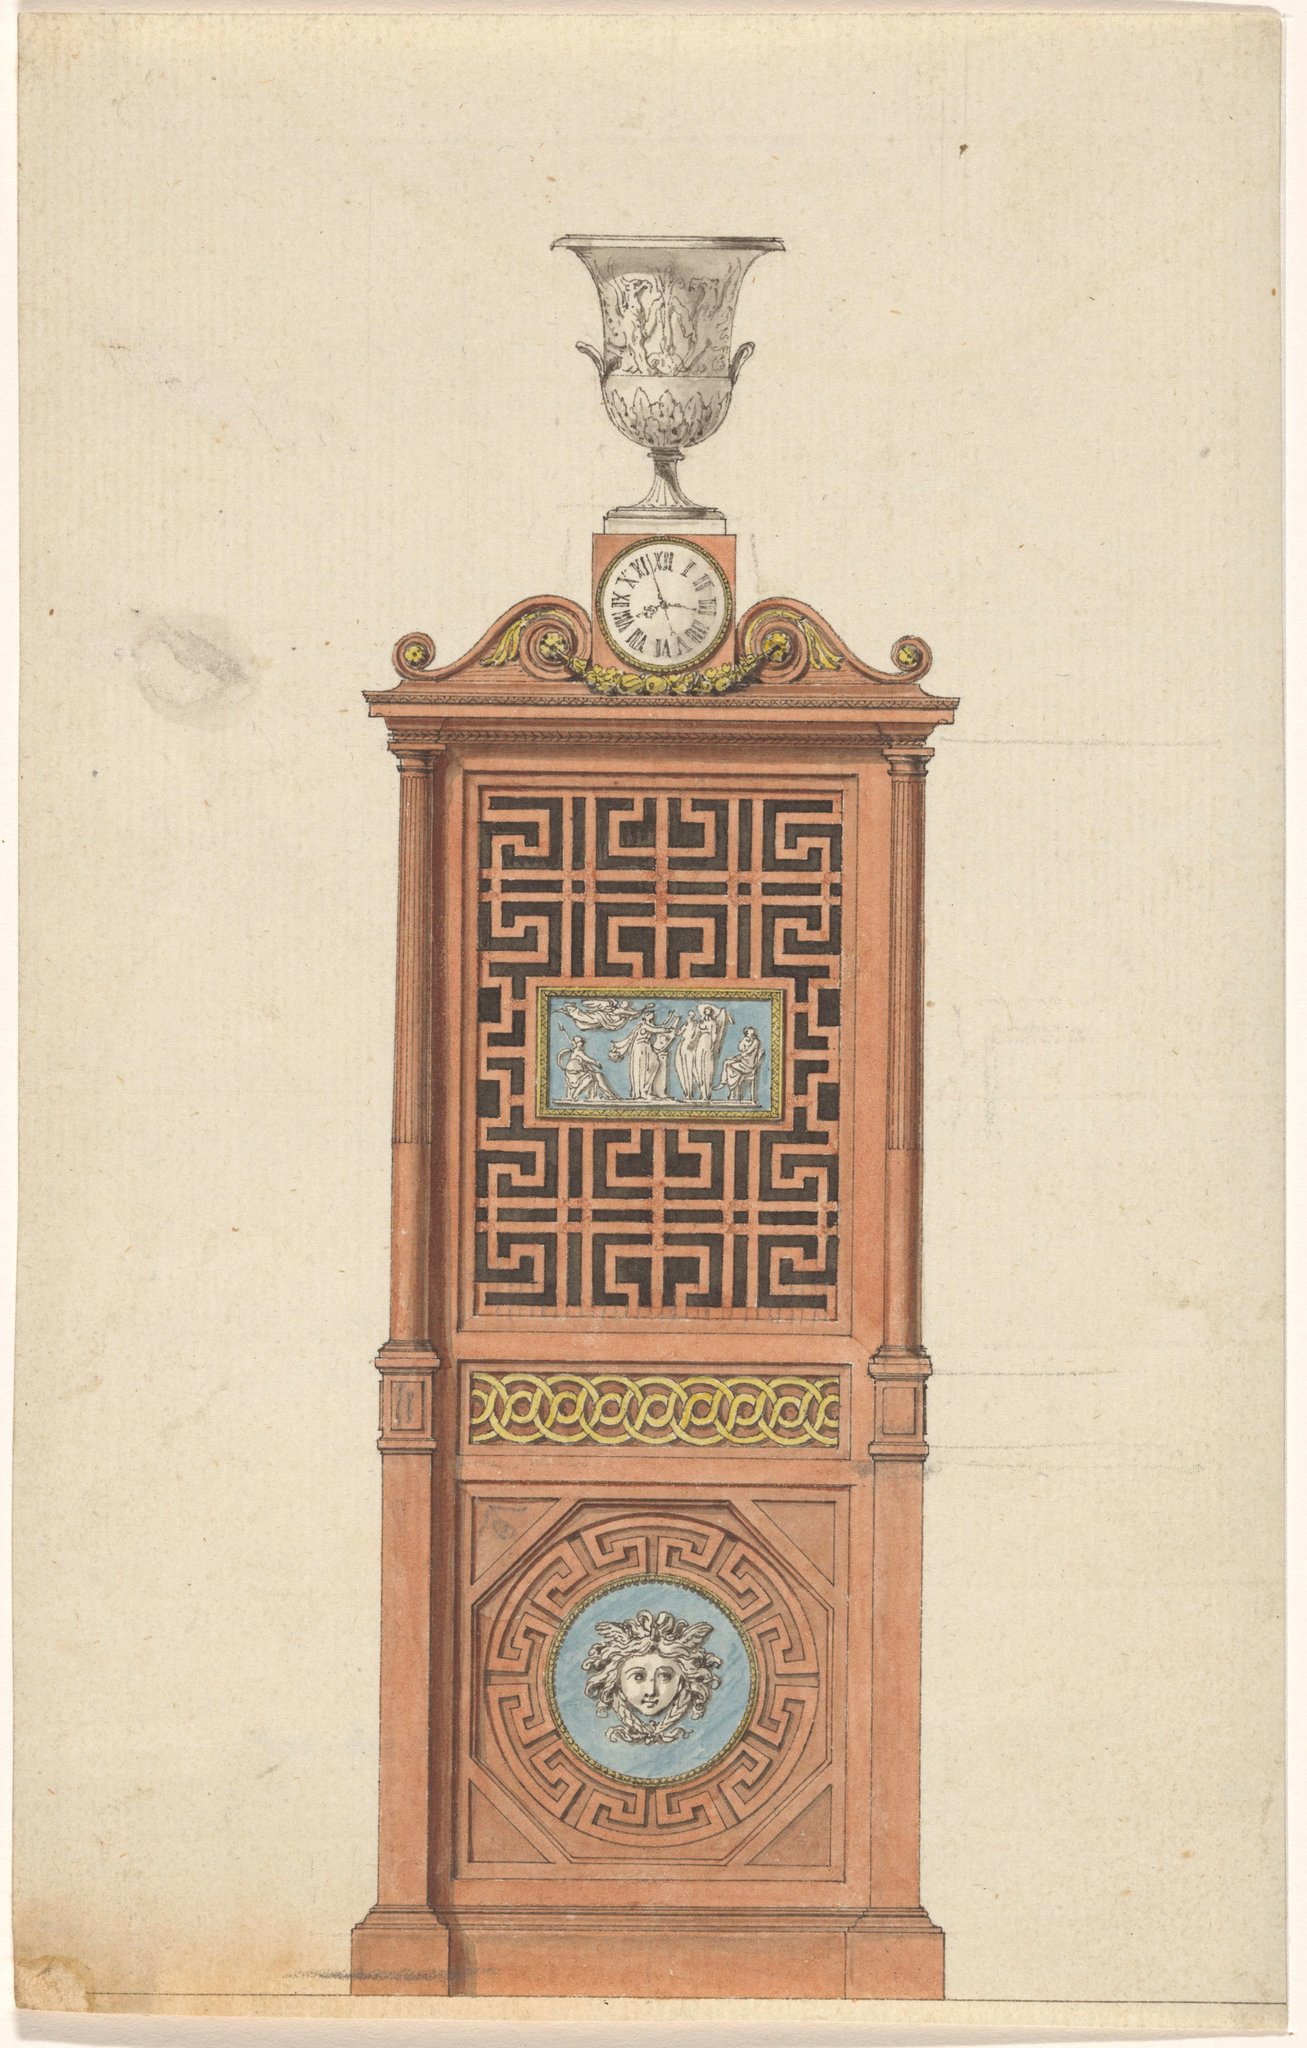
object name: design drawing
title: Ontwerp voor een orgelpendule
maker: Anonymous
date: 1785-1790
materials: graphite, paper, watercolor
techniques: brush, pen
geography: paris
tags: organ, clock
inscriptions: watermark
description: Orgelpendule, ingelegd met twee blauw-witte plaquettes, vermoedelijk van Sèvres porselein, opengewerkt met een Chinees aandoend geometrisch patroon, bekroond door een witte vaas met griffioenen.